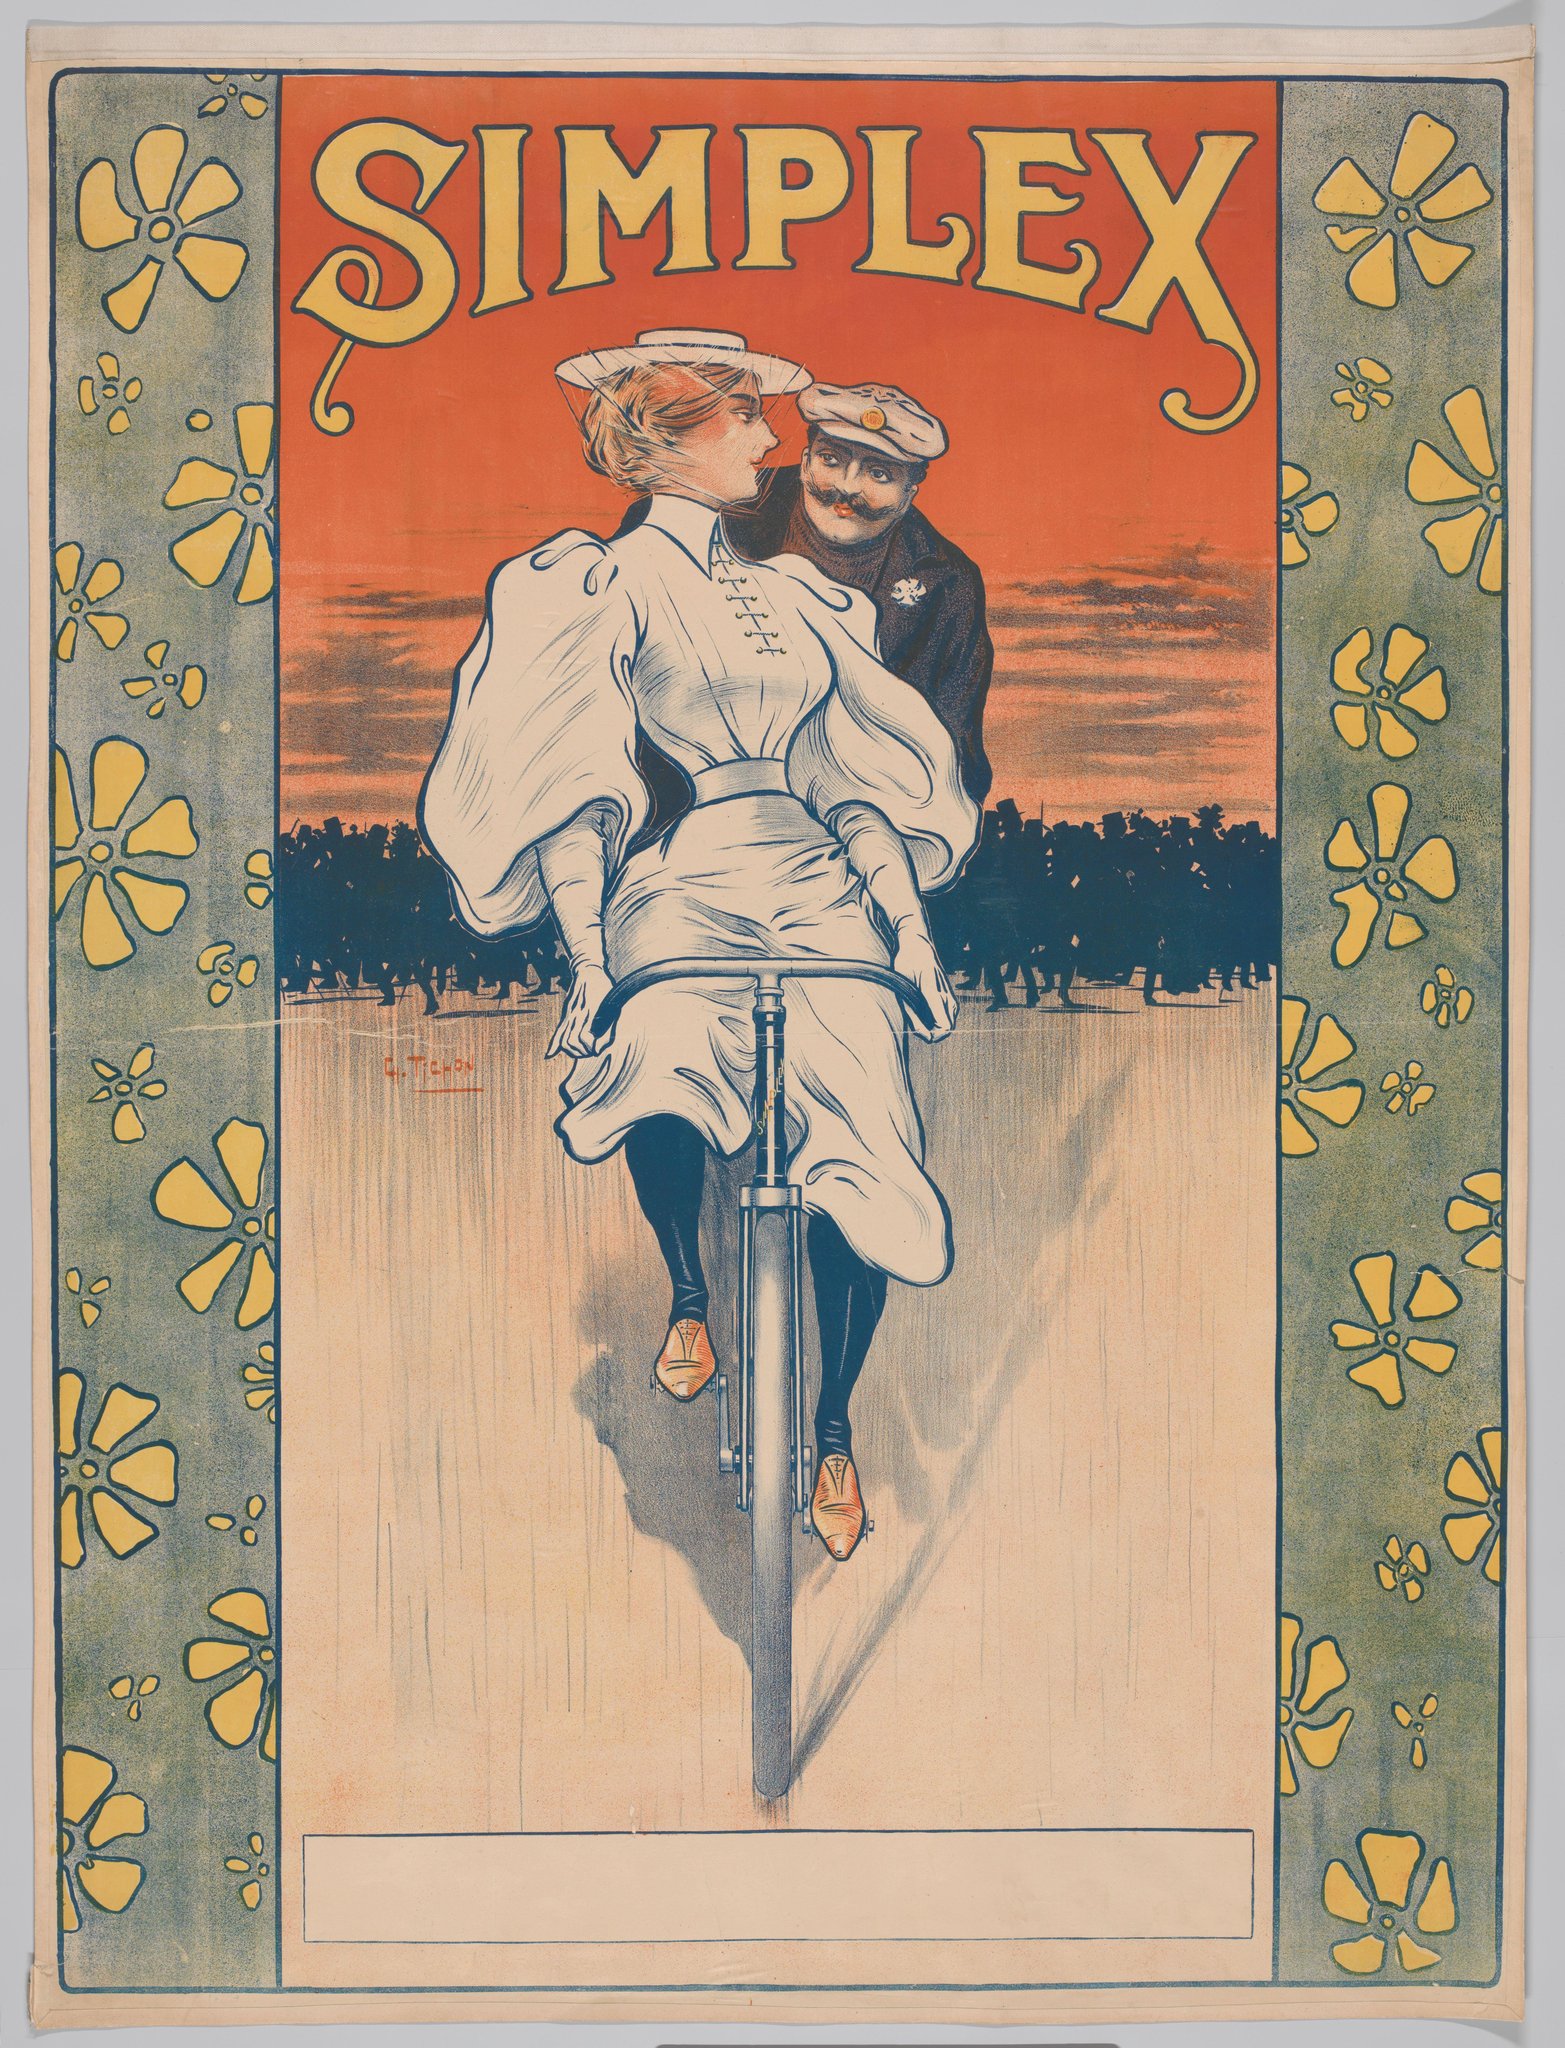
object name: poster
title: Simplex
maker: charles tichon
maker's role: draughtsman, painter, print maker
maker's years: 1865-1924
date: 1910-1912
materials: paper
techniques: lithograph